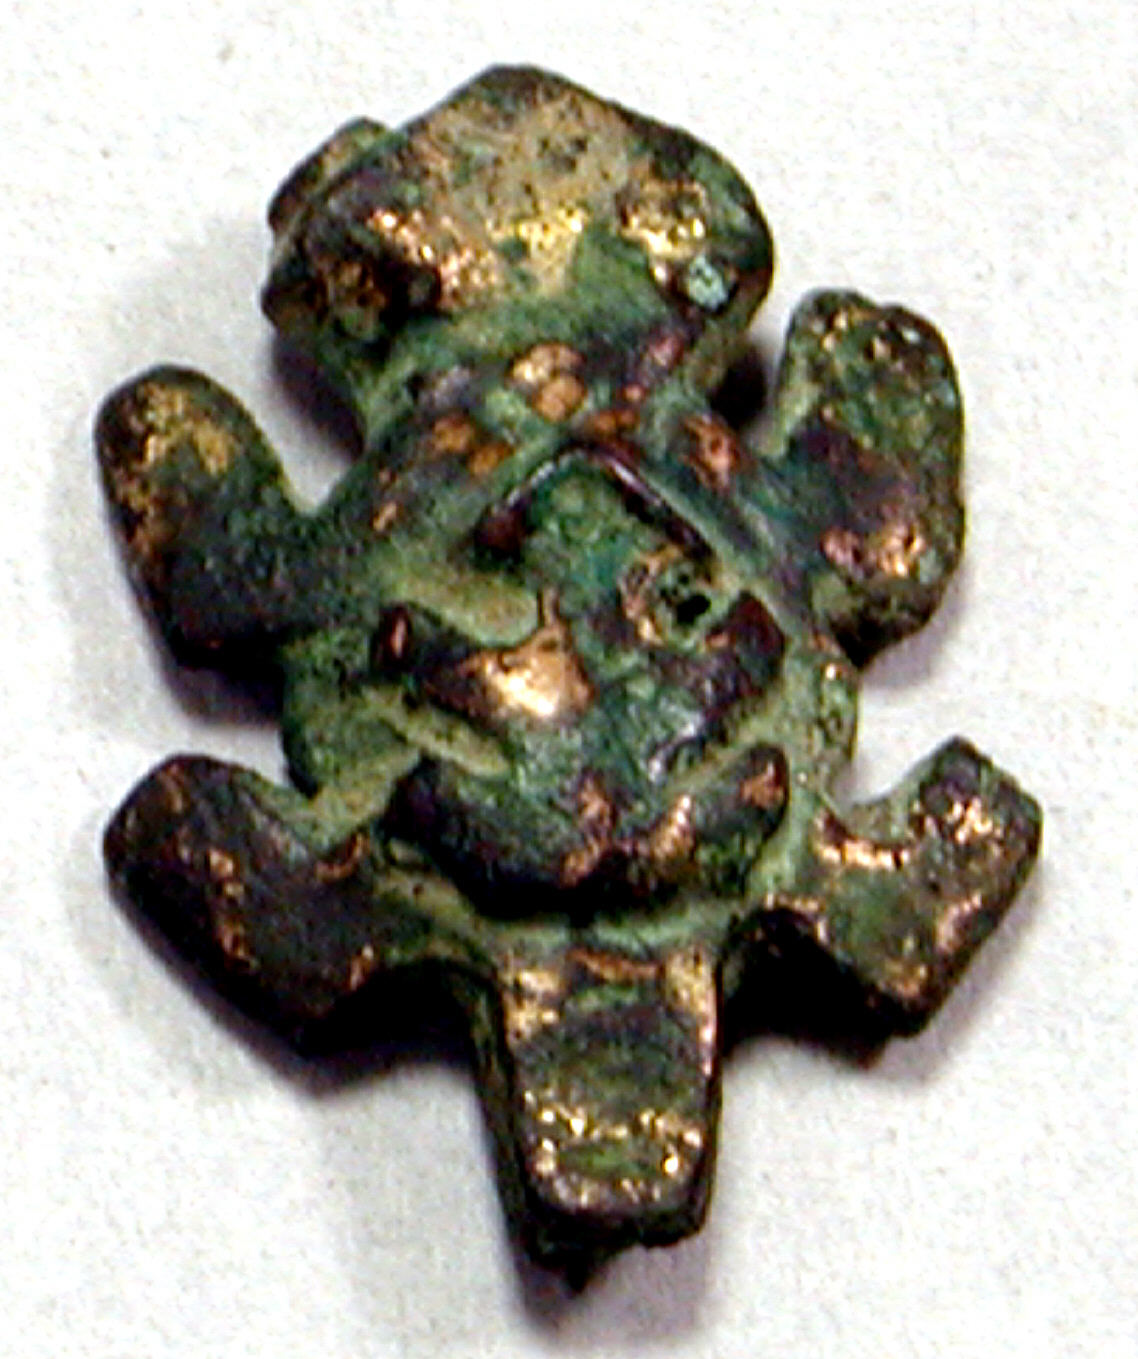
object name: figure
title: Piggyback Copper Frogs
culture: peruvian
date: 901-1500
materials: copper, gilt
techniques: casting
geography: peru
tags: frogs